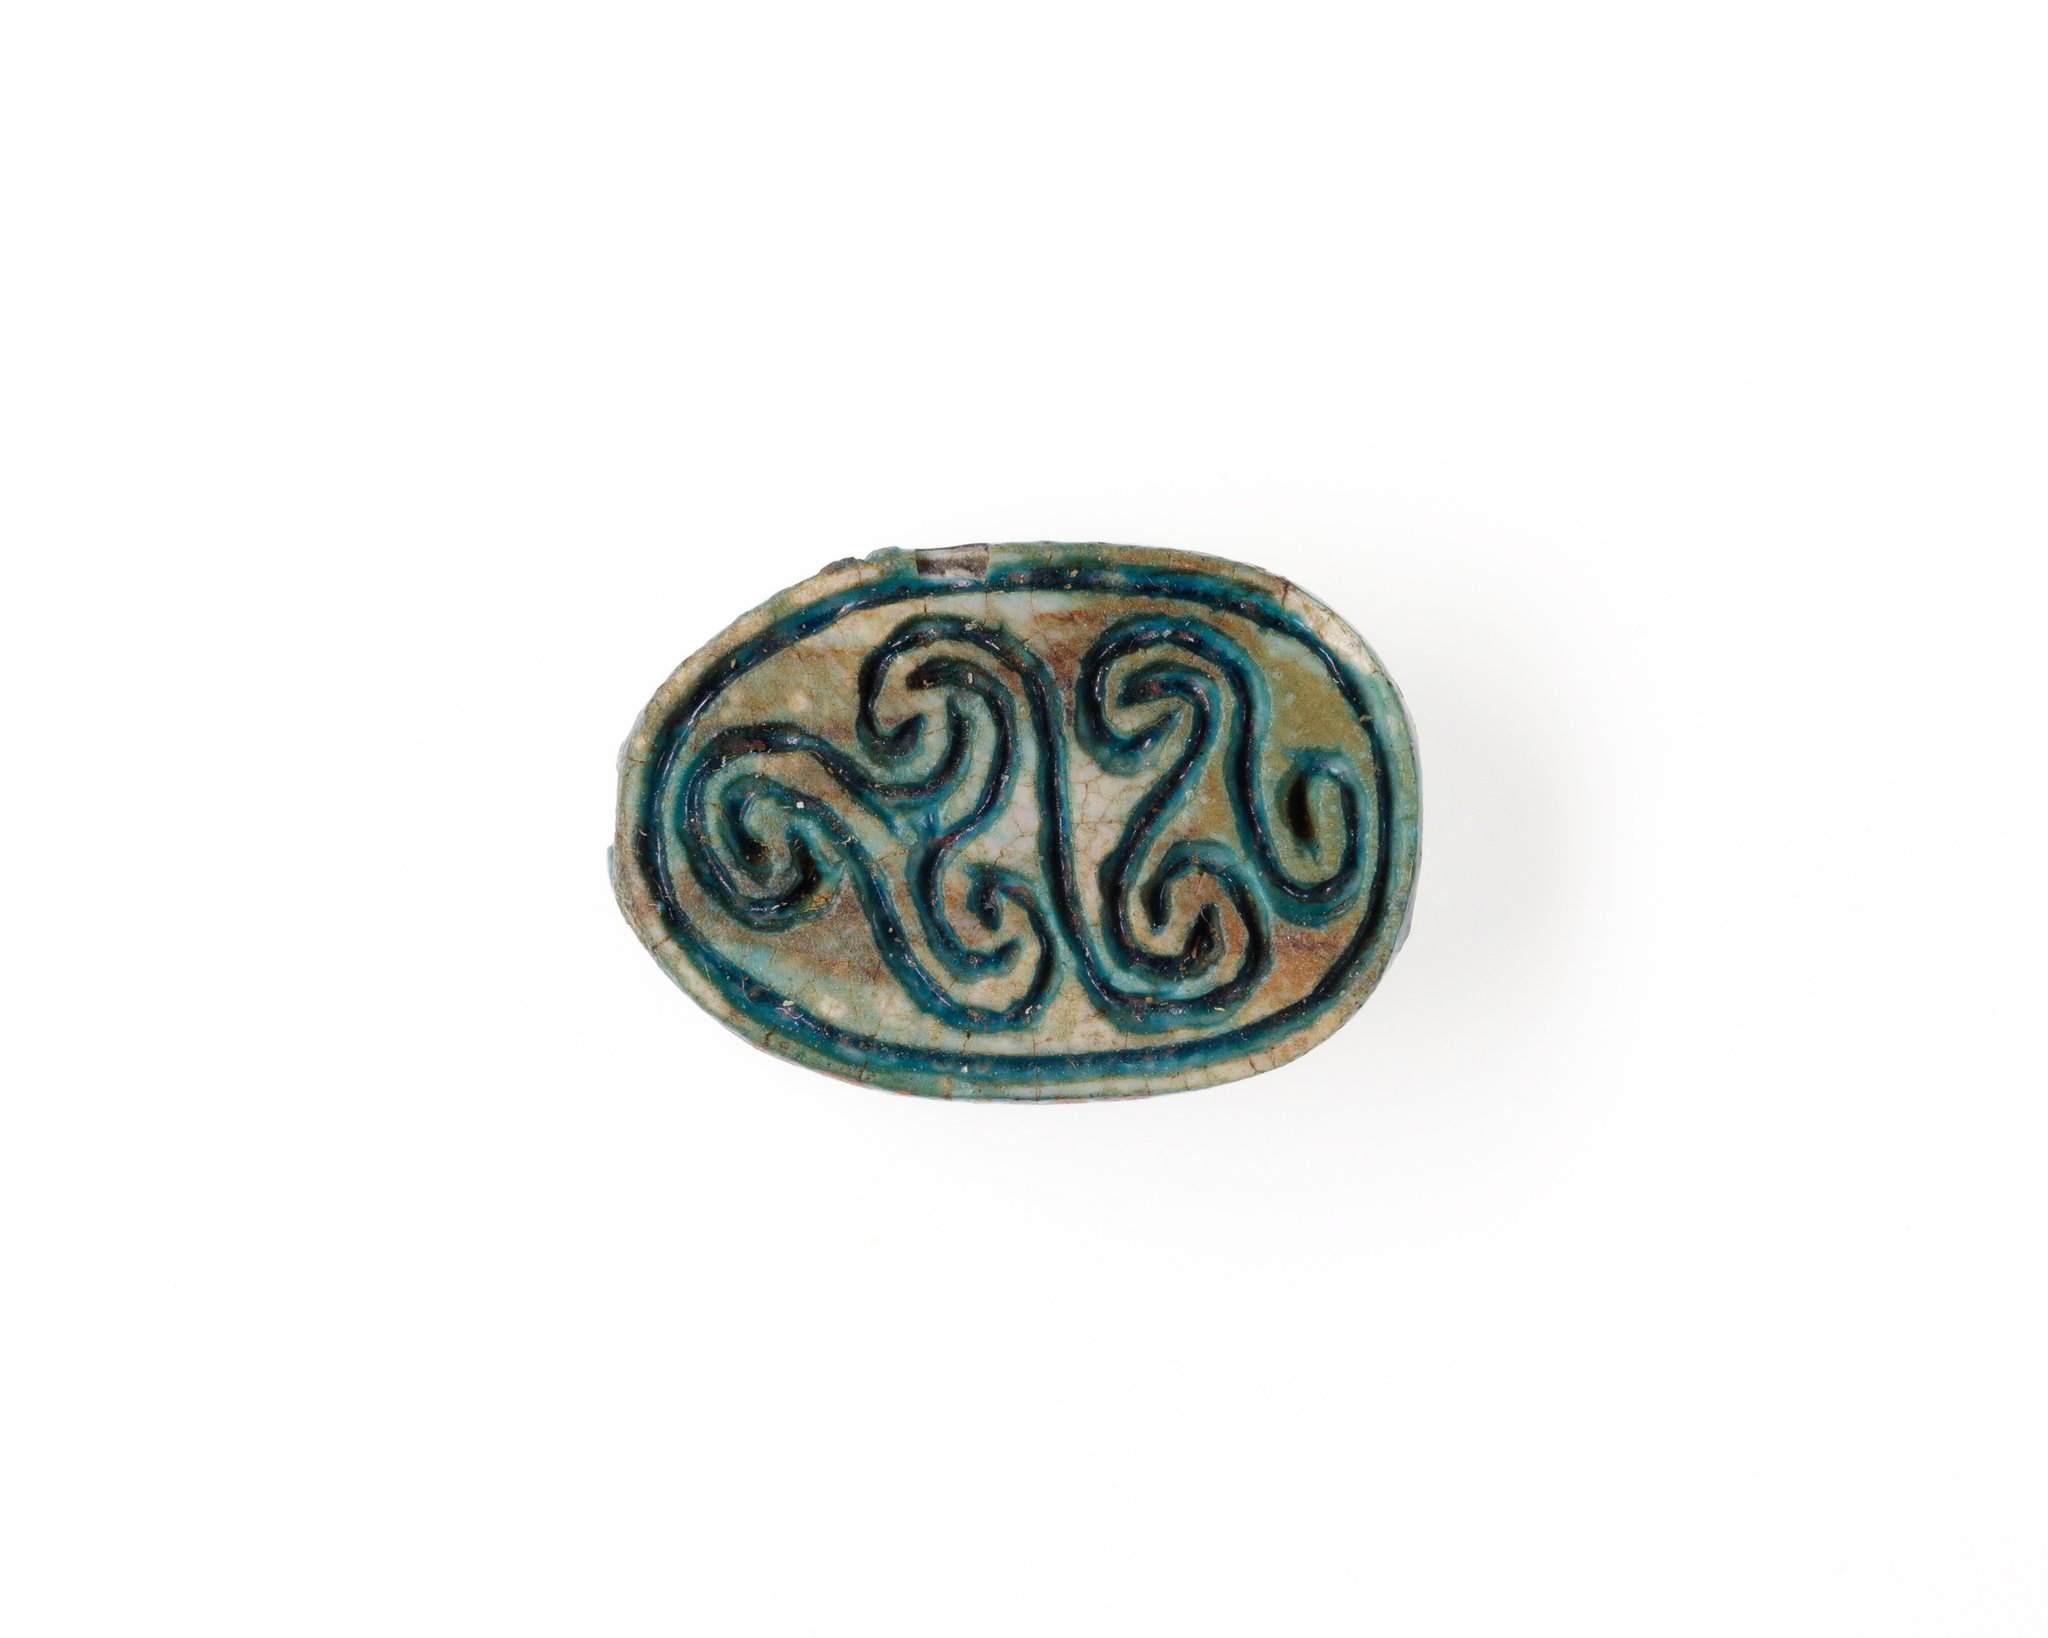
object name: scarab, scroll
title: Scarab Decorated with Scrolls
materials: stone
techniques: glazing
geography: egypt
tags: scarabs